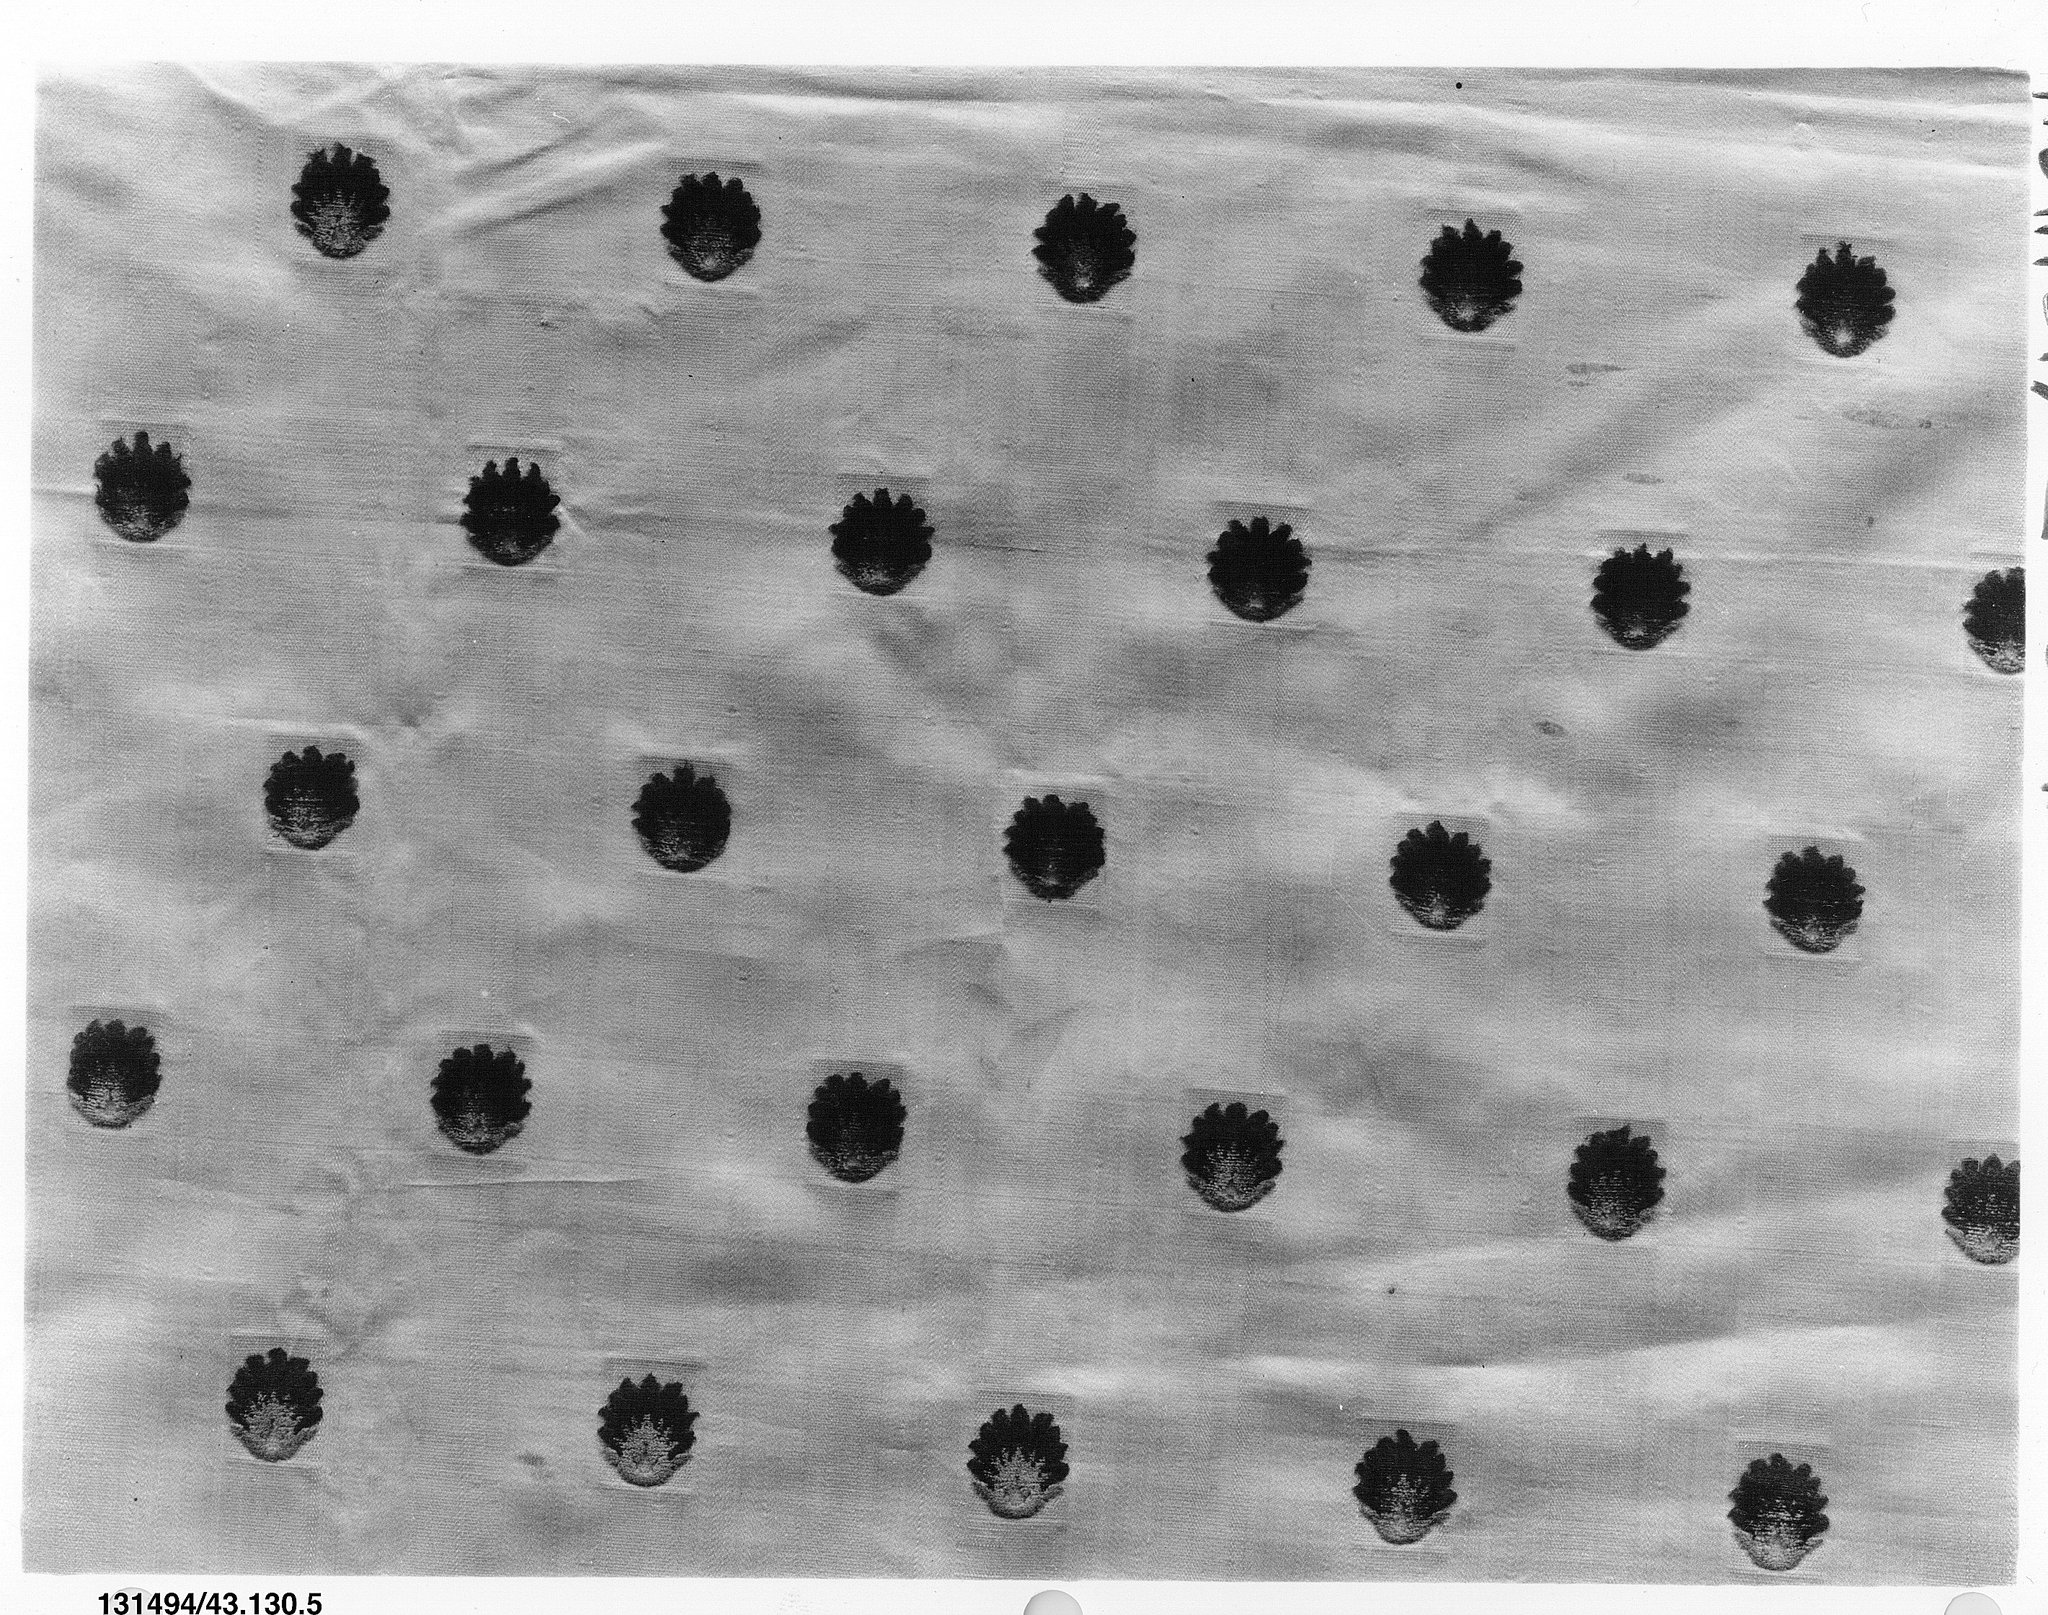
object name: piece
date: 1801-1833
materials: silk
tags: flowers